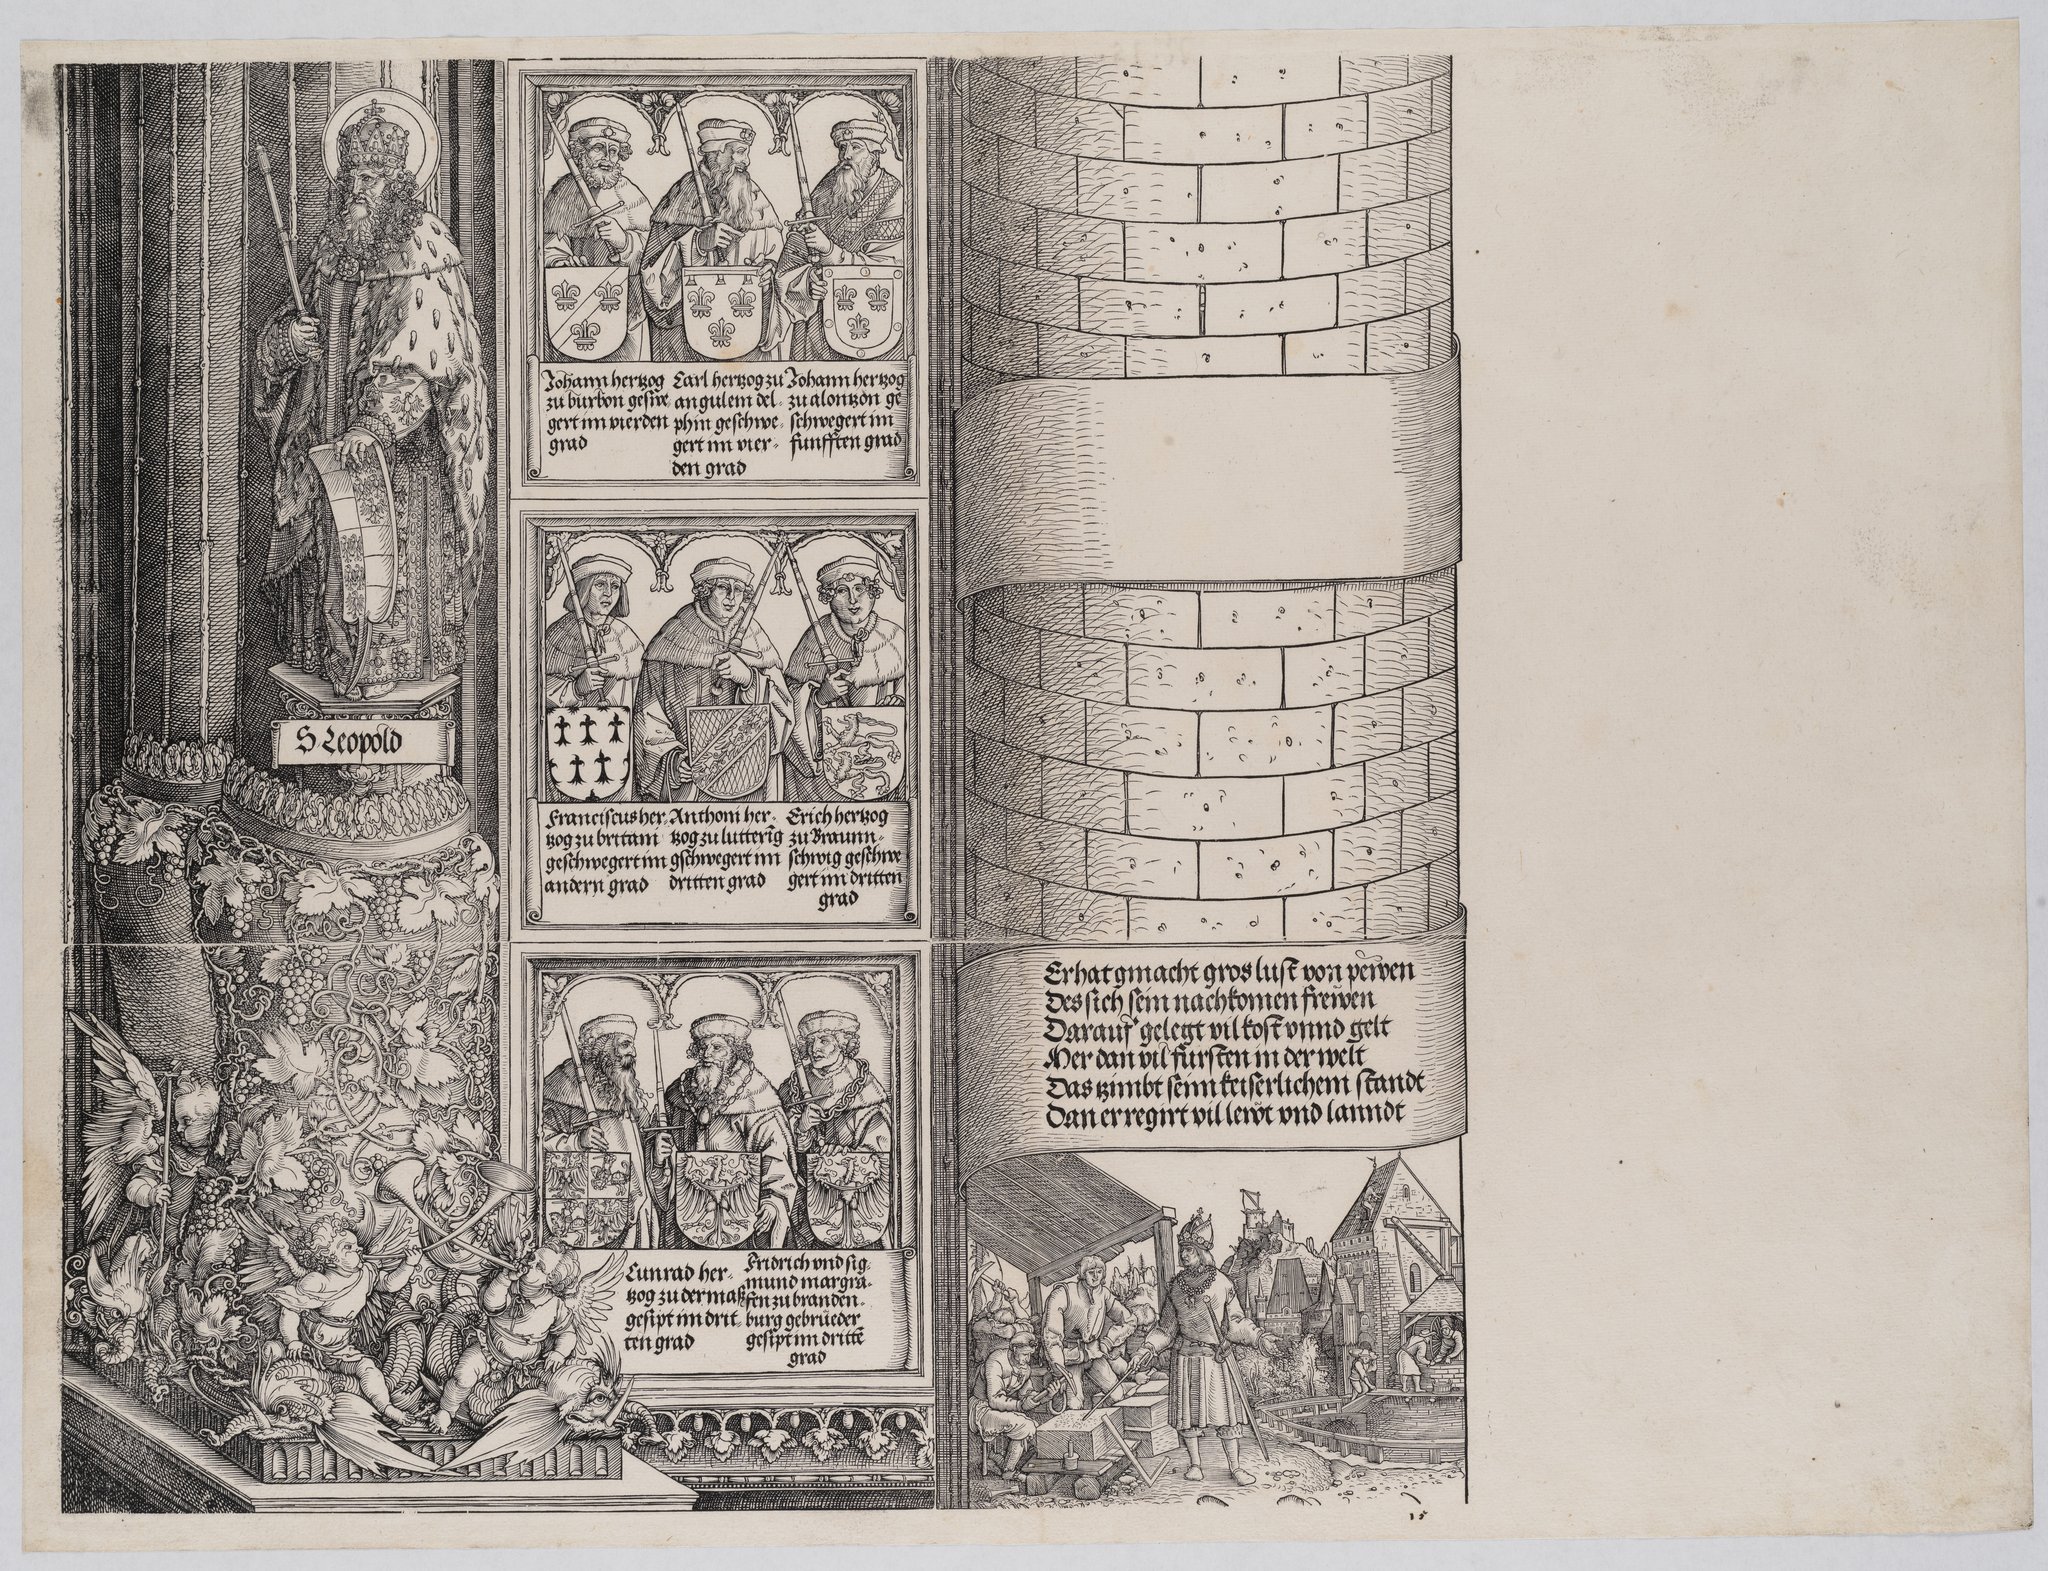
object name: print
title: Maximilian as Architect; with a Statue of St. Leopold; and Busts of Maximilian's Ancestors and Relatives, from the Arch of Honor, proof, dated 1515, printed 1517-18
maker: albrecht dürer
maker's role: artist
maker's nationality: german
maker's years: 1471-1528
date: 1517-1518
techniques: letterpress, woodcut